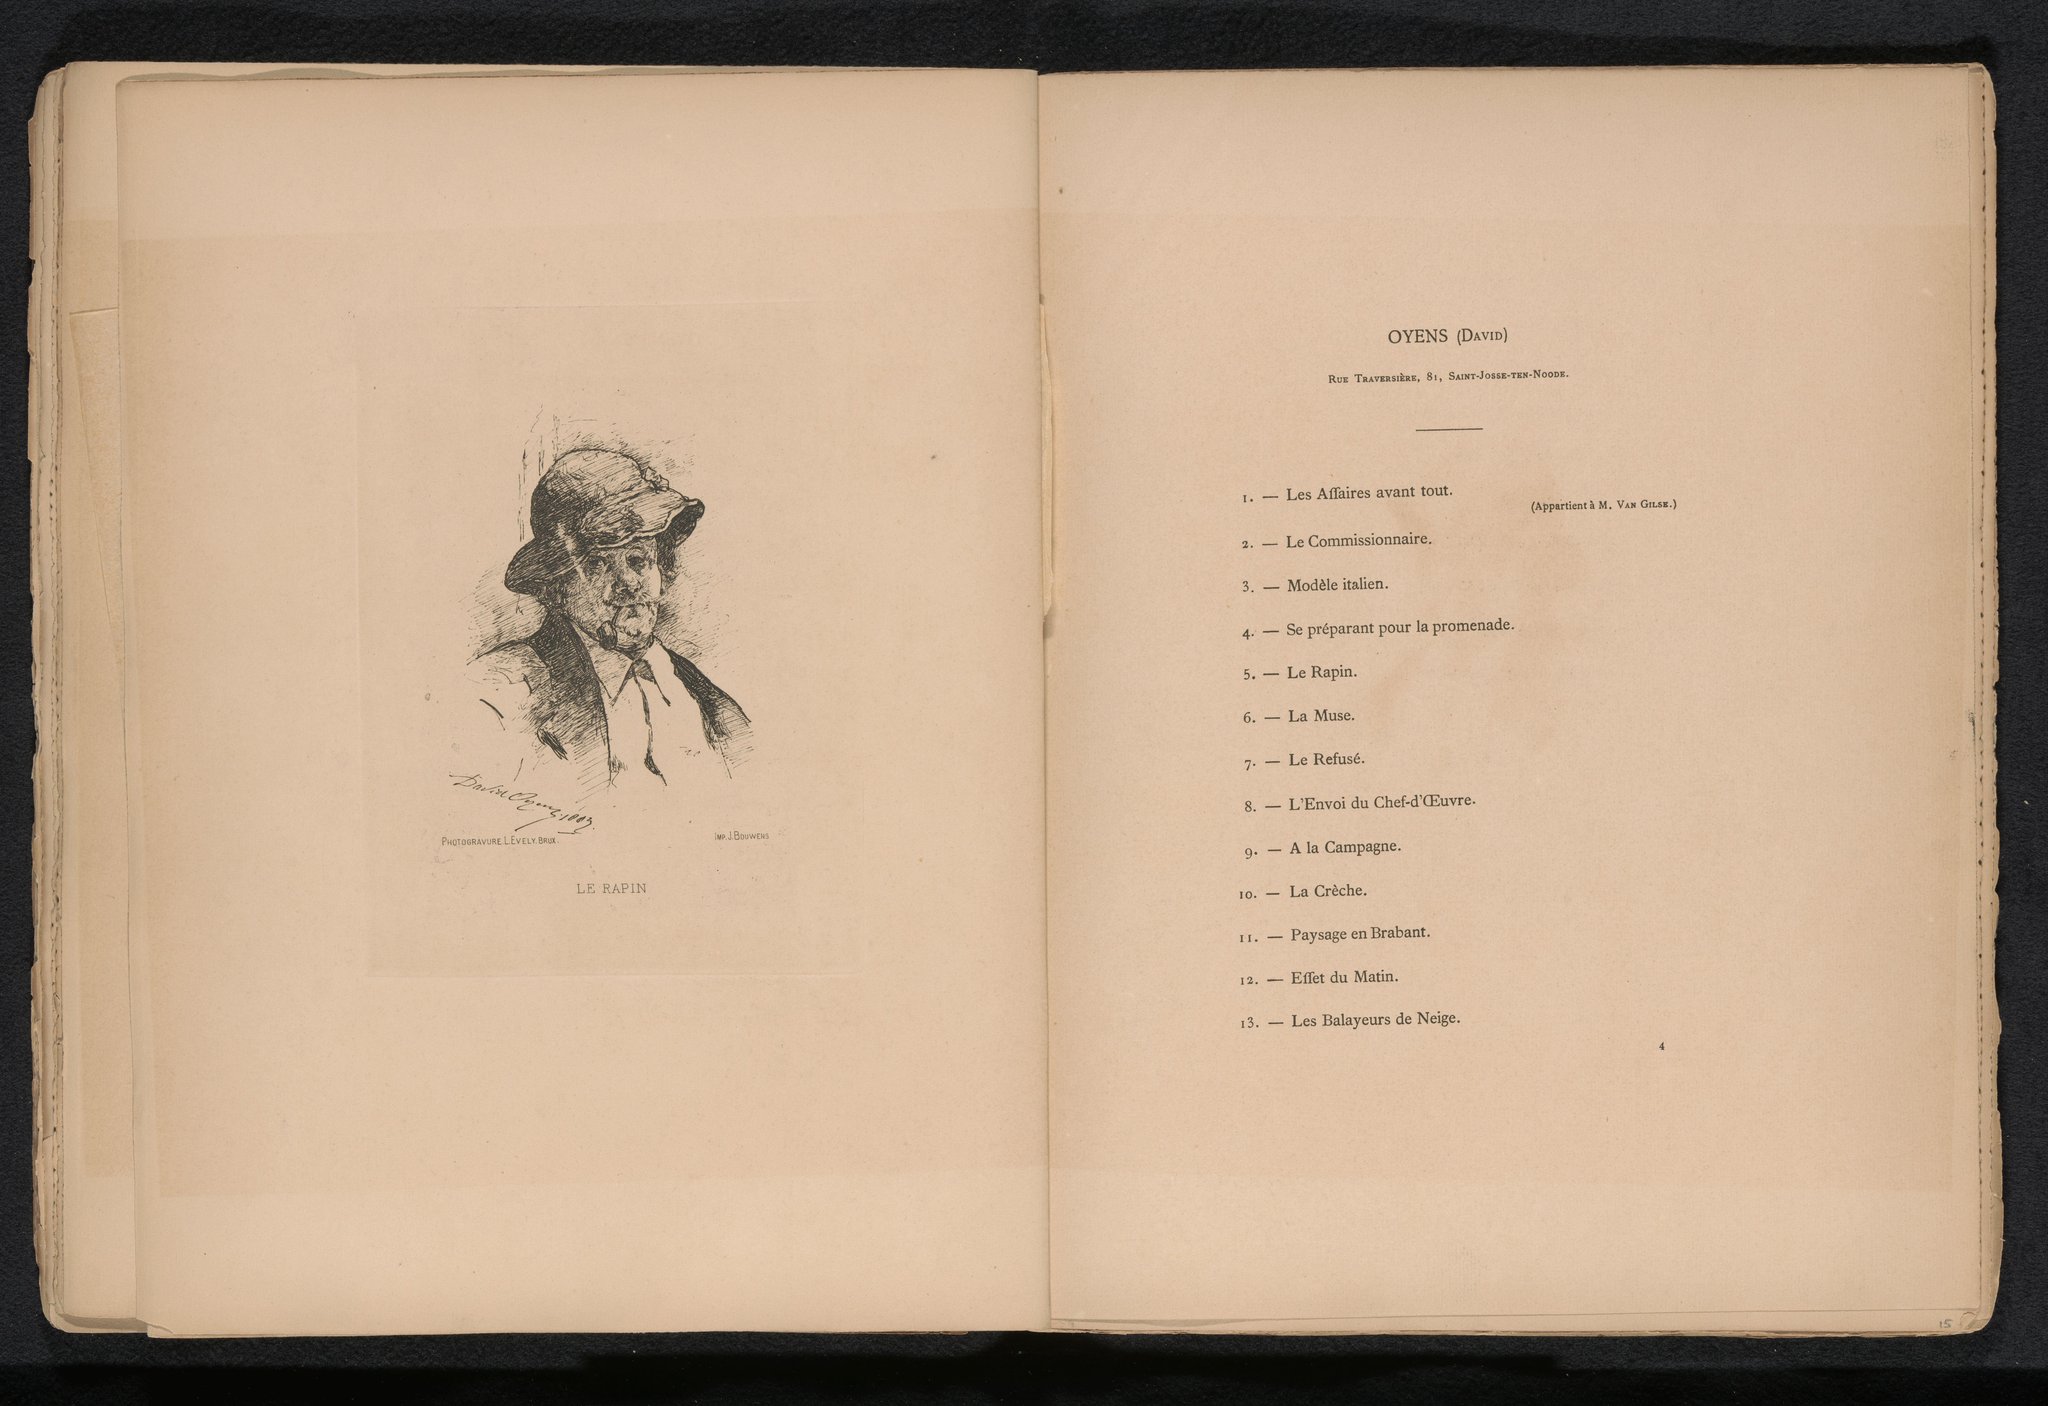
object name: photomechanical print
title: Reproductie van een tekening van een pijprokende man door David Oyens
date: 1883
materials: paper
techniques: photoaquatint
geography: brussels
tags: adult man, pipe ~ tobacco